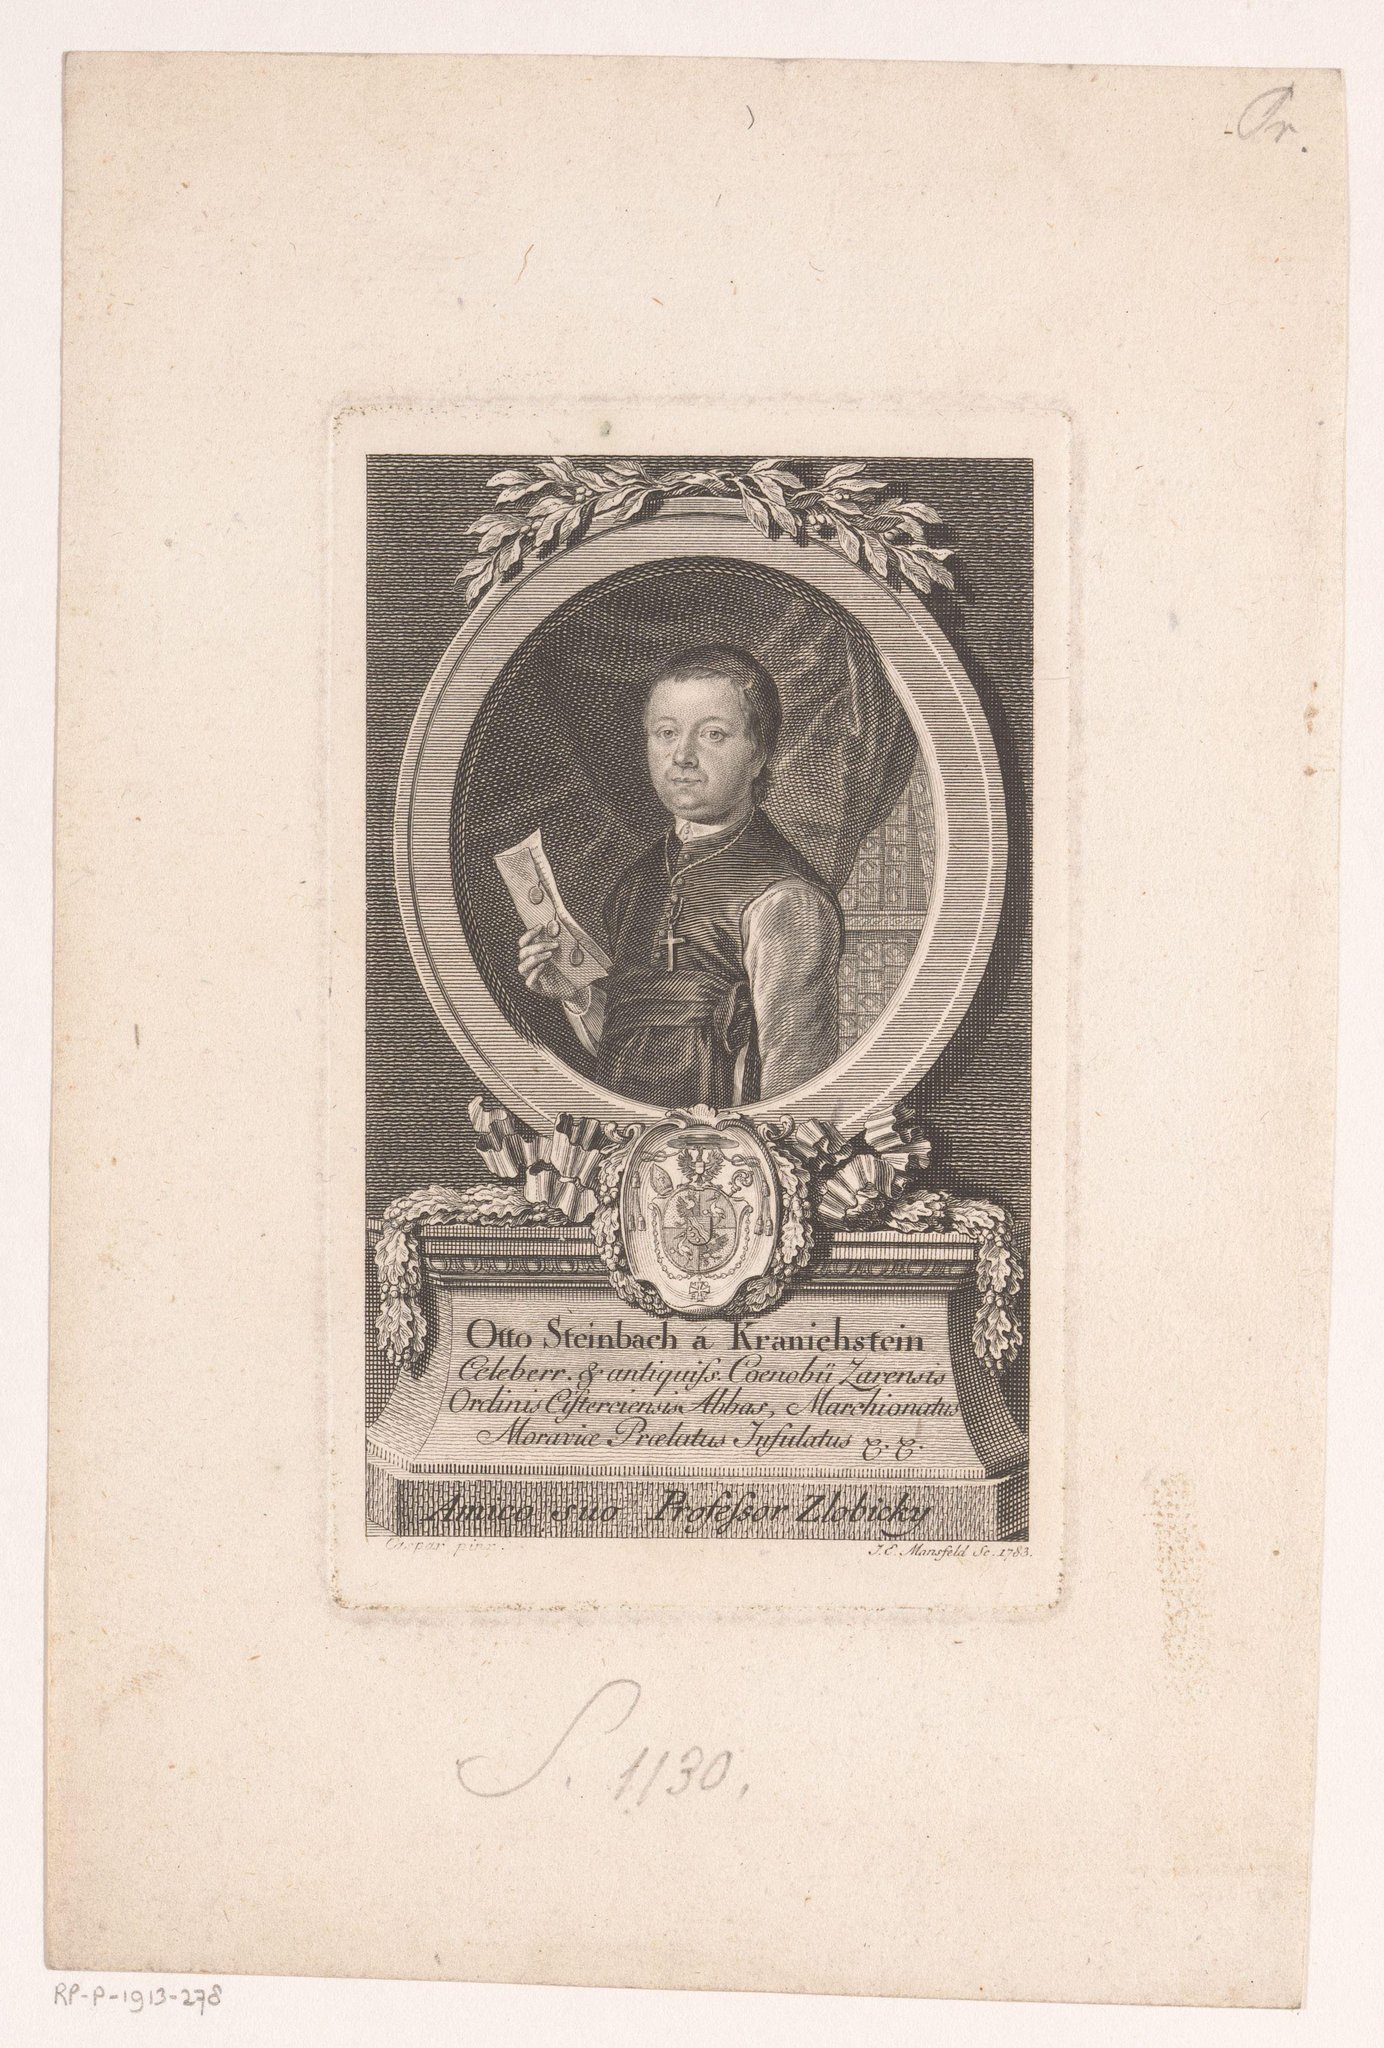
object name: print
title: Portret van Otto von Steinbach-Kranichstein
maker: johann ernst mansfeld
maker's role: print maker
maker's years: 1739-1796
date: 1783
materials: paper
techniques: engraving, etching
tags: historical persons, armorial bearing, heraldry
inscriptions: collector's mark: Lugt 2228